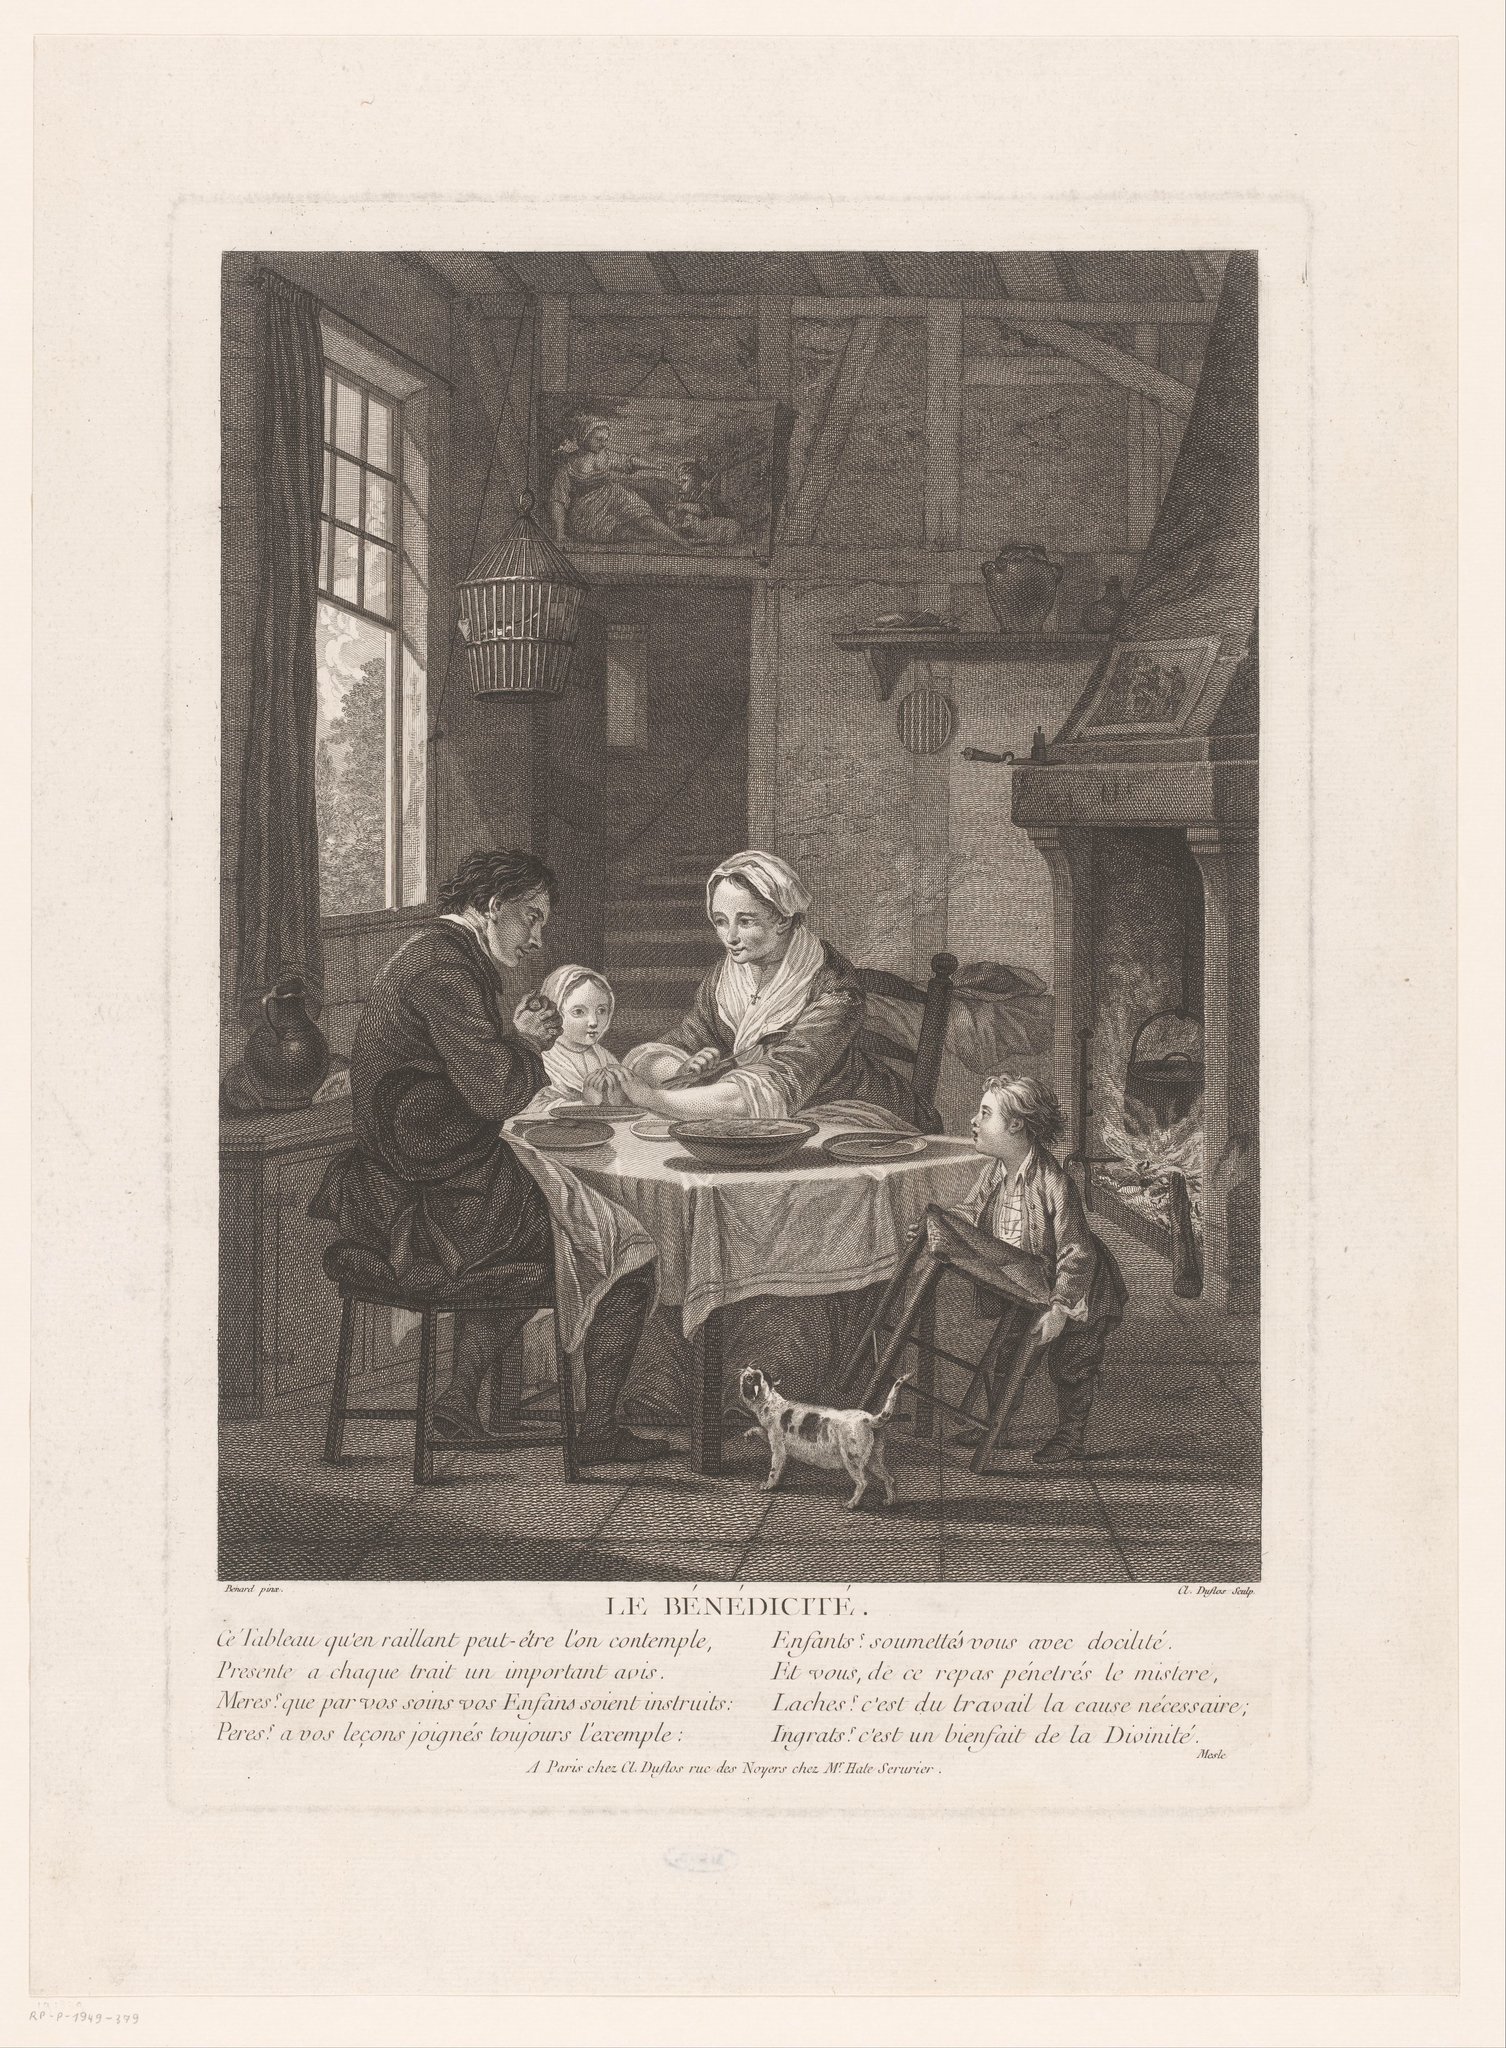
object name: print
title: Interieur met gezin dat het eten zegent aan tafel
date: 1710-1786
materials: paper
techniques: engraving, etching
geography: france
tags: interior of the house, prayer at table, saying grace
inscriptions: collector's mark: Lugt 2228